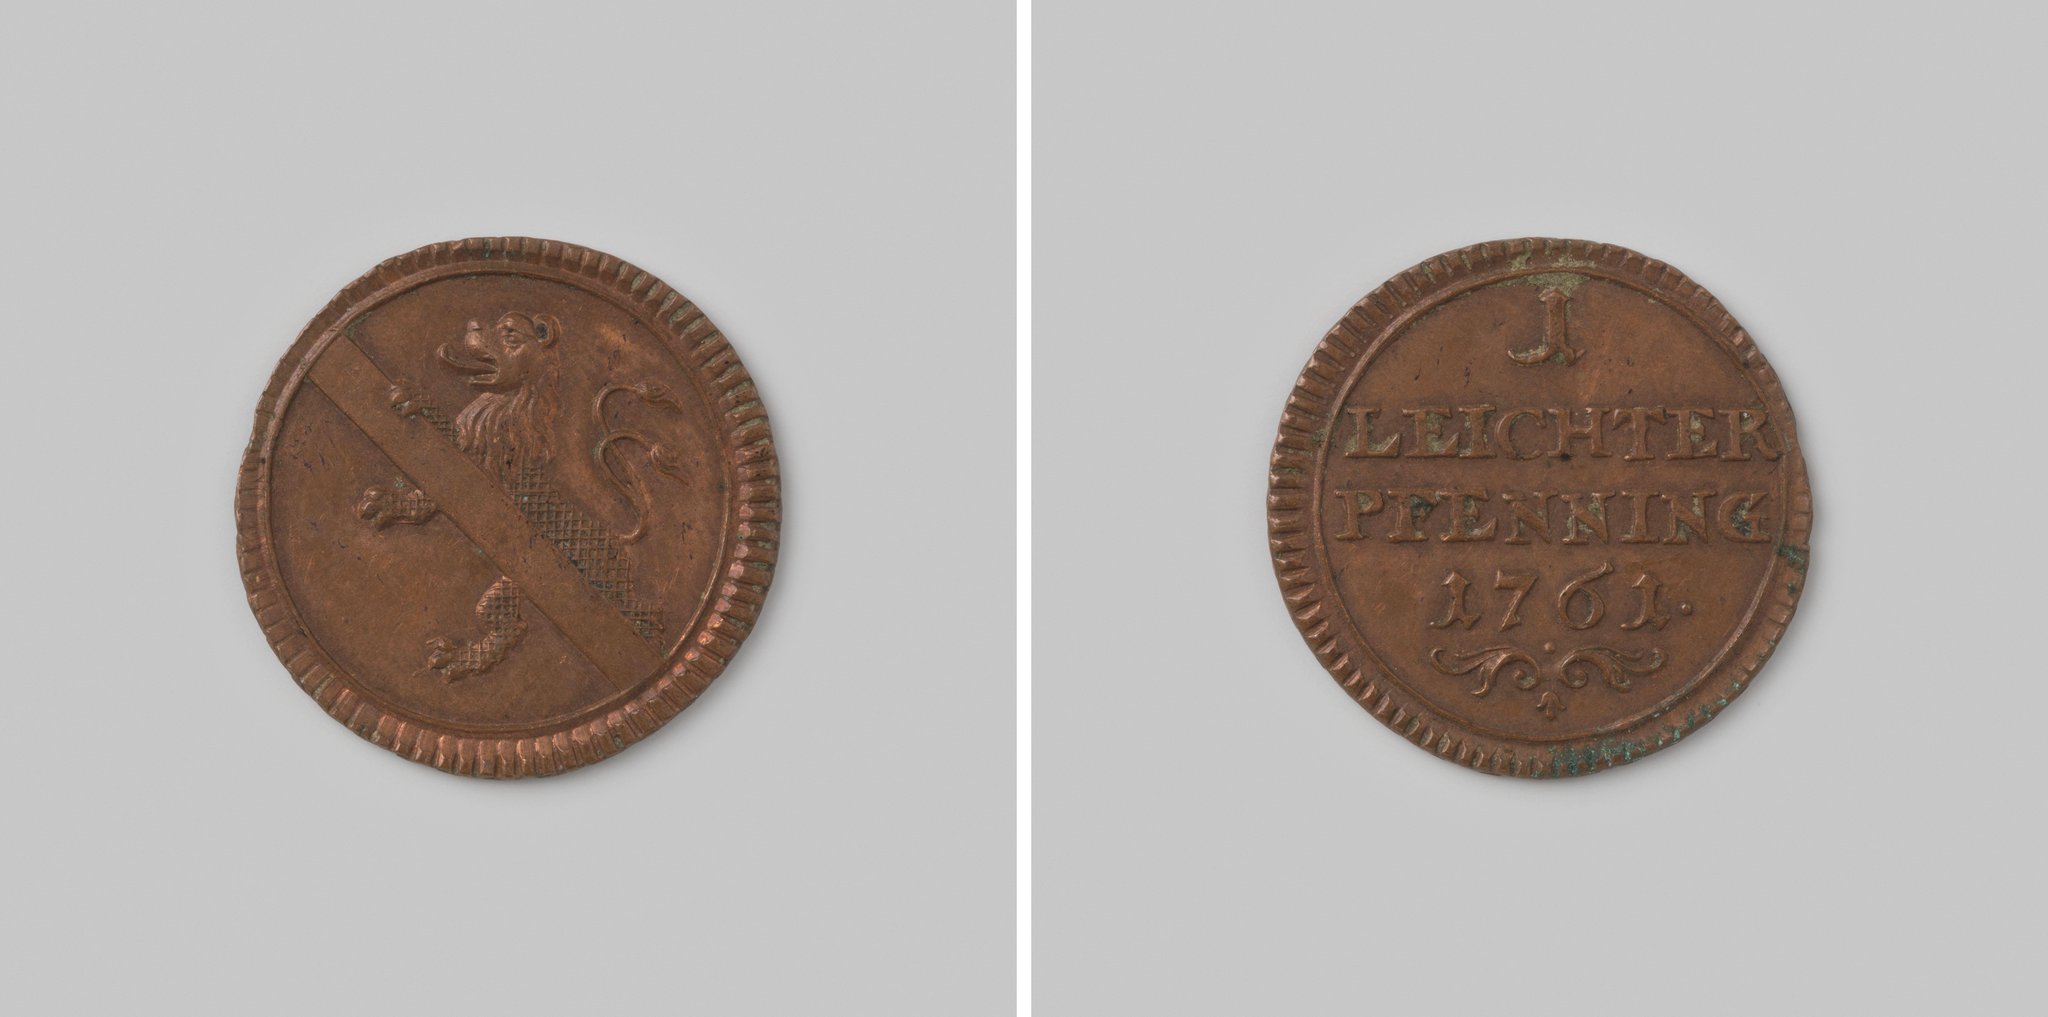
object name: coin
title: Bisdom Bamberg, Adam Friedrich van Seinsheim, Leichter pfenning, 1761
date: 1761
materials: copper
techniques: striking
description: Koperen munt. Voorzijde: wapen van Bamberg in veld. Keerzijde: waarde-aanduiding in drie regels, waaronder jaartal. Daaronder versiering. Kartelrand.